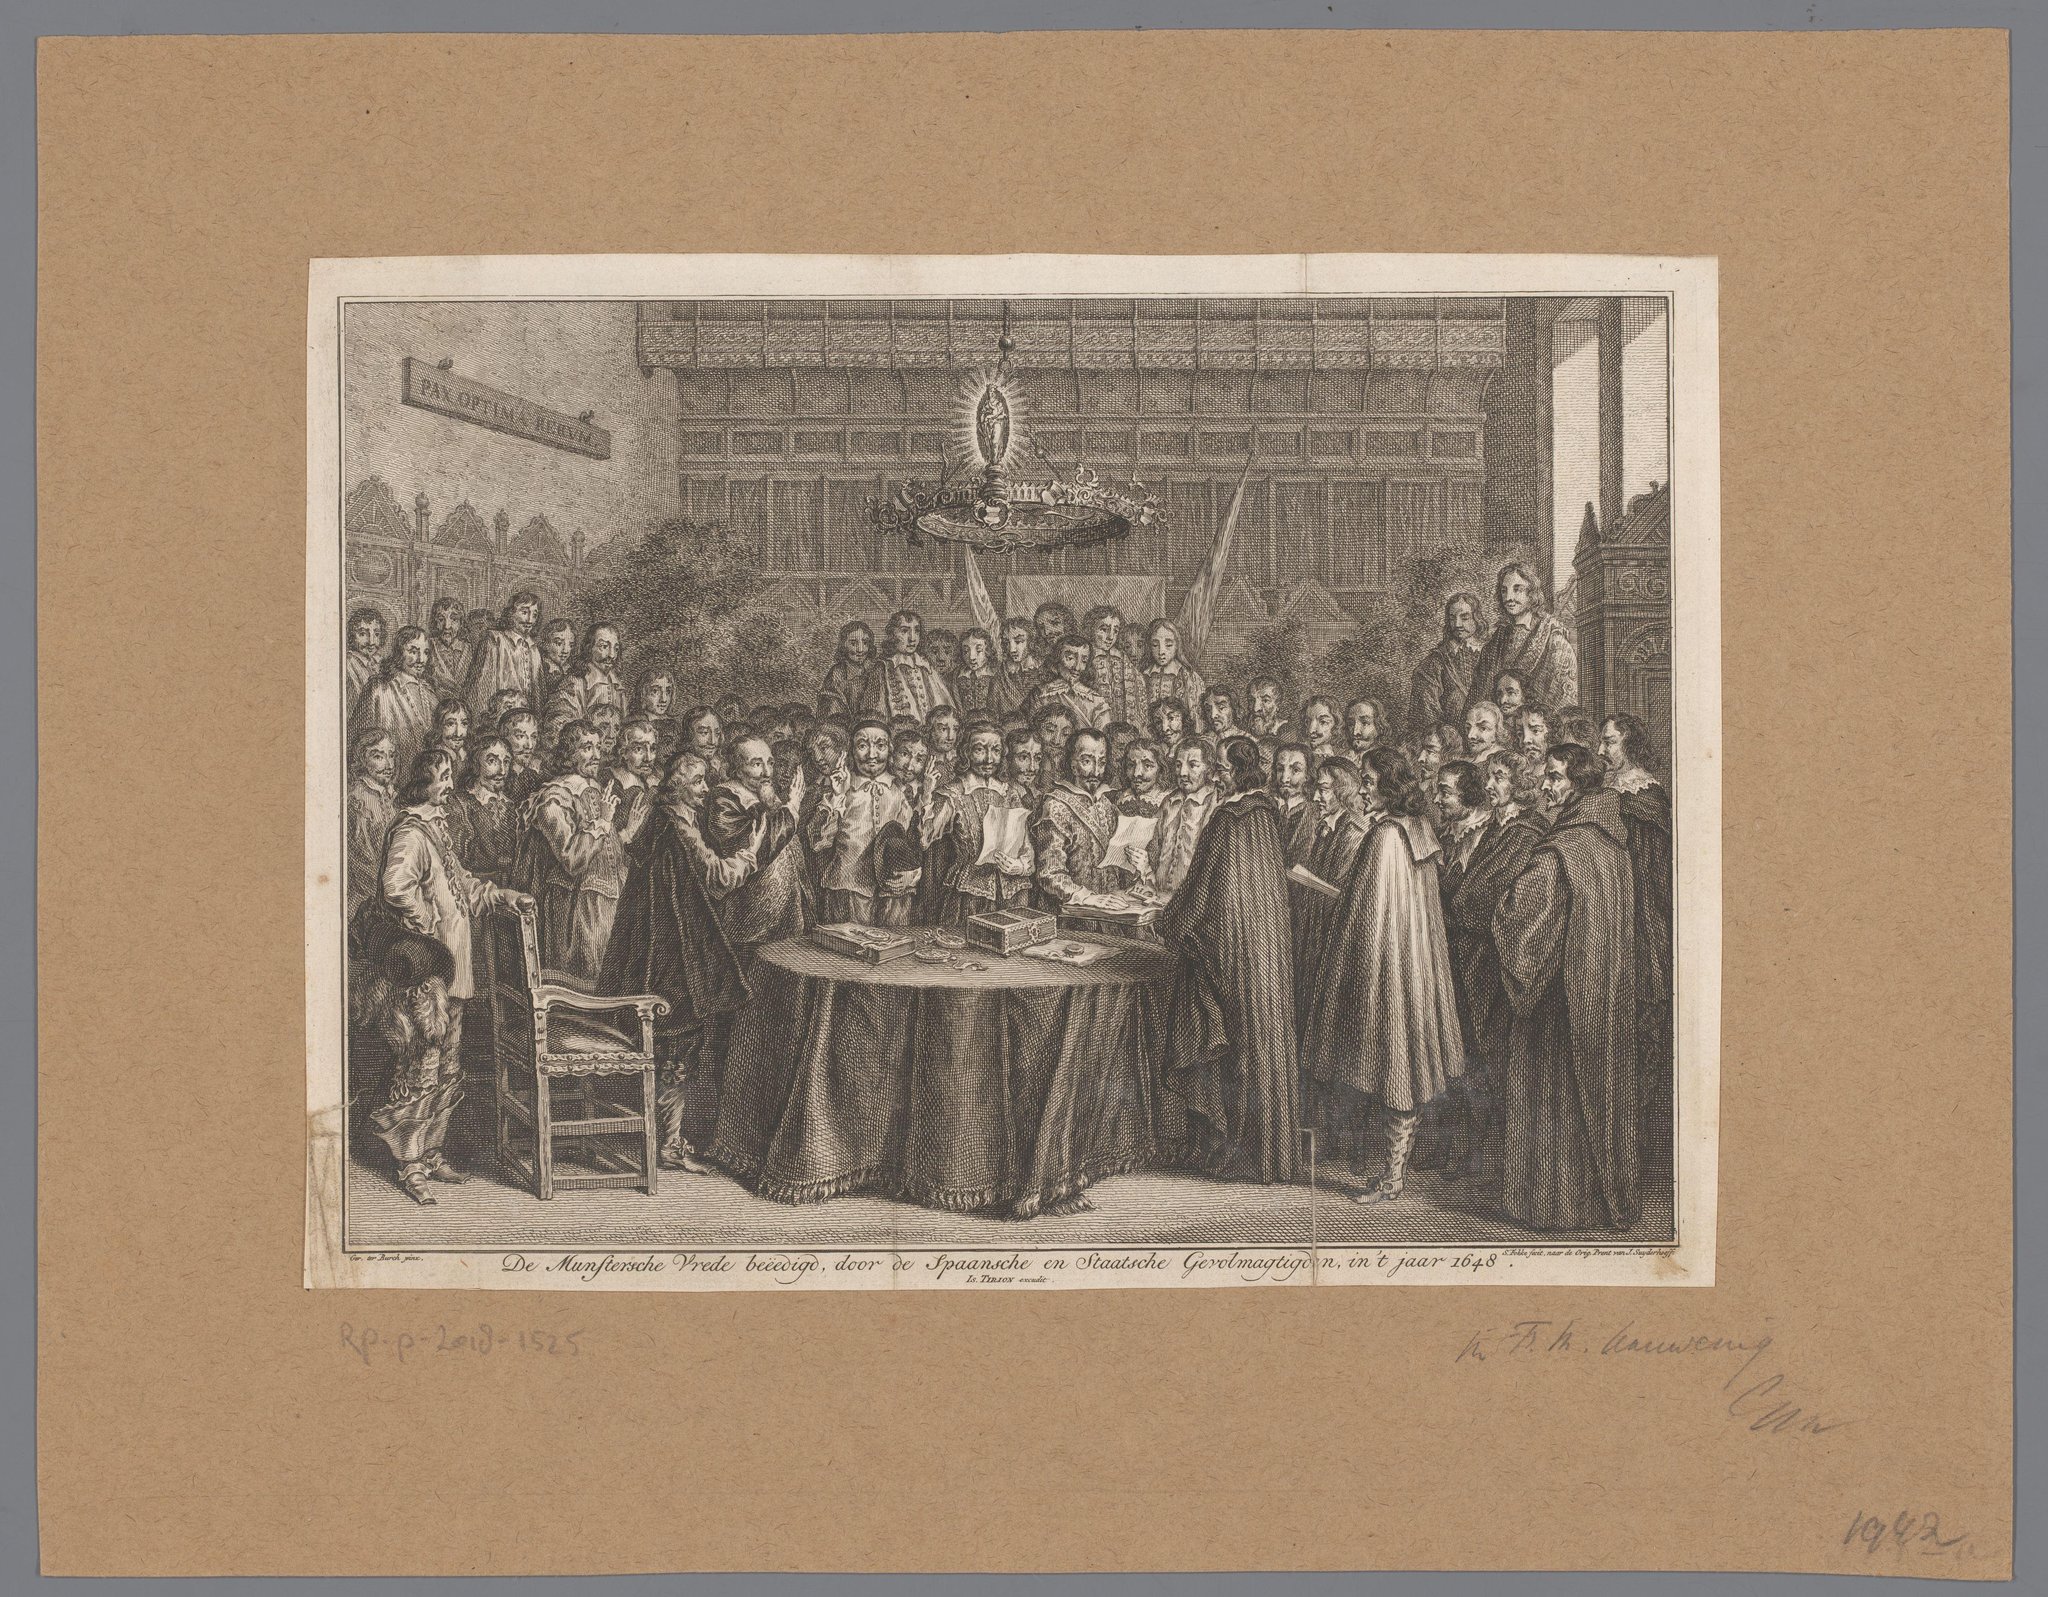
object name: print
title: Beëdiging van de Vrede van Munster, 1648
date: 1754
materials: paper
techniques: etching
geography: amsterdam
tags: signing of peace treaty, concluding the peace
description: Het beëdigen van de Vrede van Munster op 15 mei 1648, in de grote zaal of Friedenssaal van het stadhuis te Munster. De afgevaardigden staan rond een tafel en leggen met opgestoken hand de eed af.